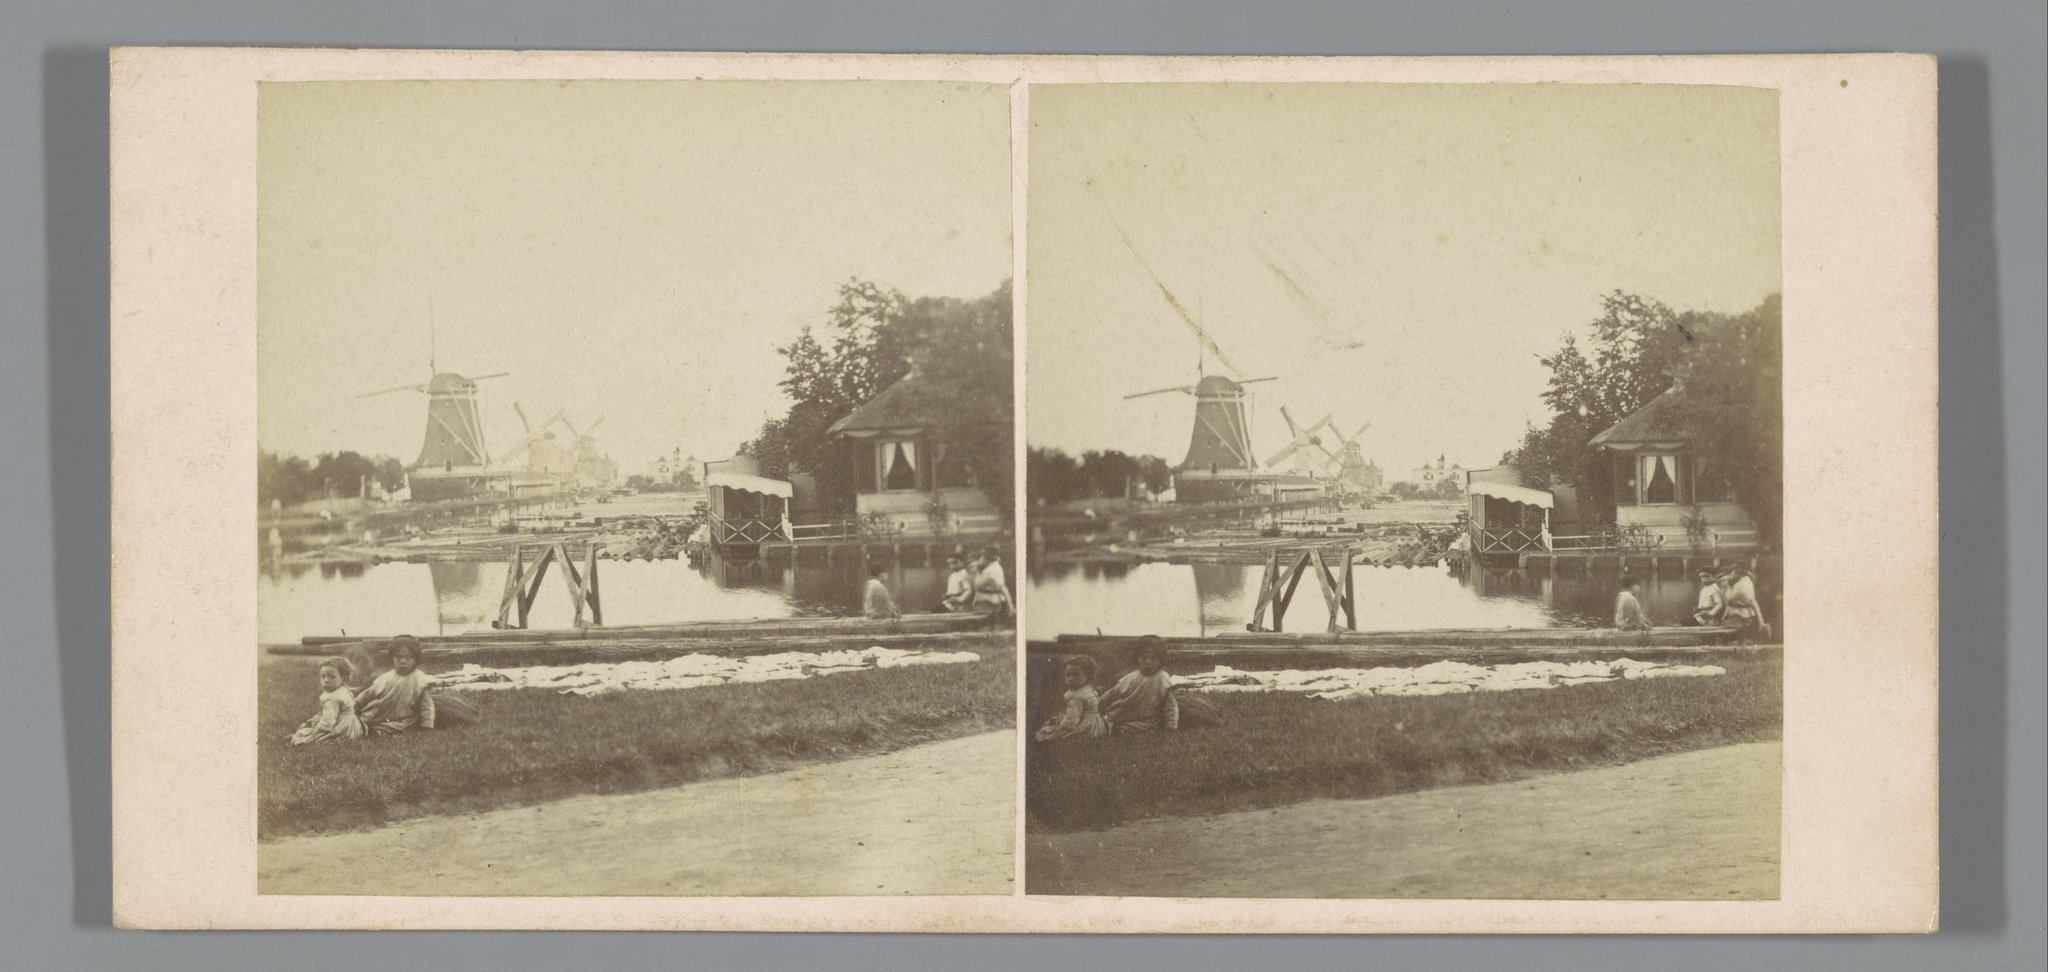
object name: stereograph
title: Gezicht op het Mennonietenpad, buiten de Wetering-Barrière in Amsterdam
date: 1860-1885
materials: cardboard, photographic support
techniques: albumen print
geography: amsterdam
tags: road, path, windmill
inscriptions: inscription: ‘HET MENNONIETENPAD/ BUITEN DE/ Wetering-Barrière te Amsterdam./ A. JAGER, WATER 110, TE AMSTERDAM.’